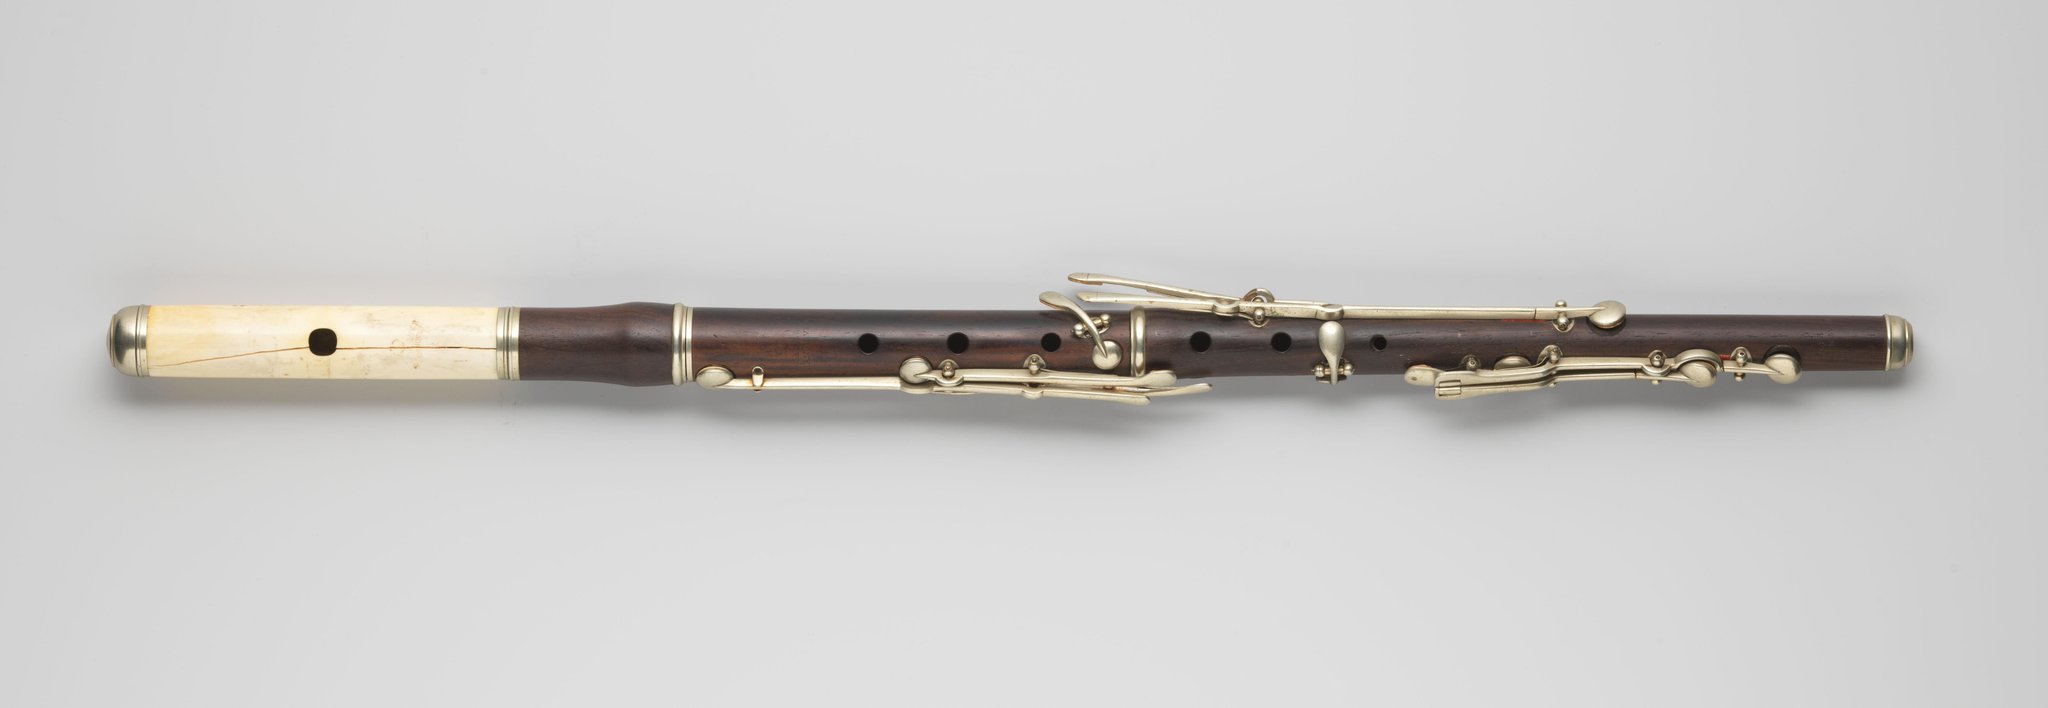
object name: flute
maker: heinrich friedrich meyer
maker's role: musical instrument maker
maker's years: 1814-1897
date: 1860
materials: metal, wood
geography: hannover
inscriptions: stamp: ‘HF Meyer / HANNOVER’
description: Driedelige dwarsfluit van grenadille met 10 kleppen (zilver?). Ivoren kop met metaal gevoerd en houten stemschuif. Stemming a=468 Hz.